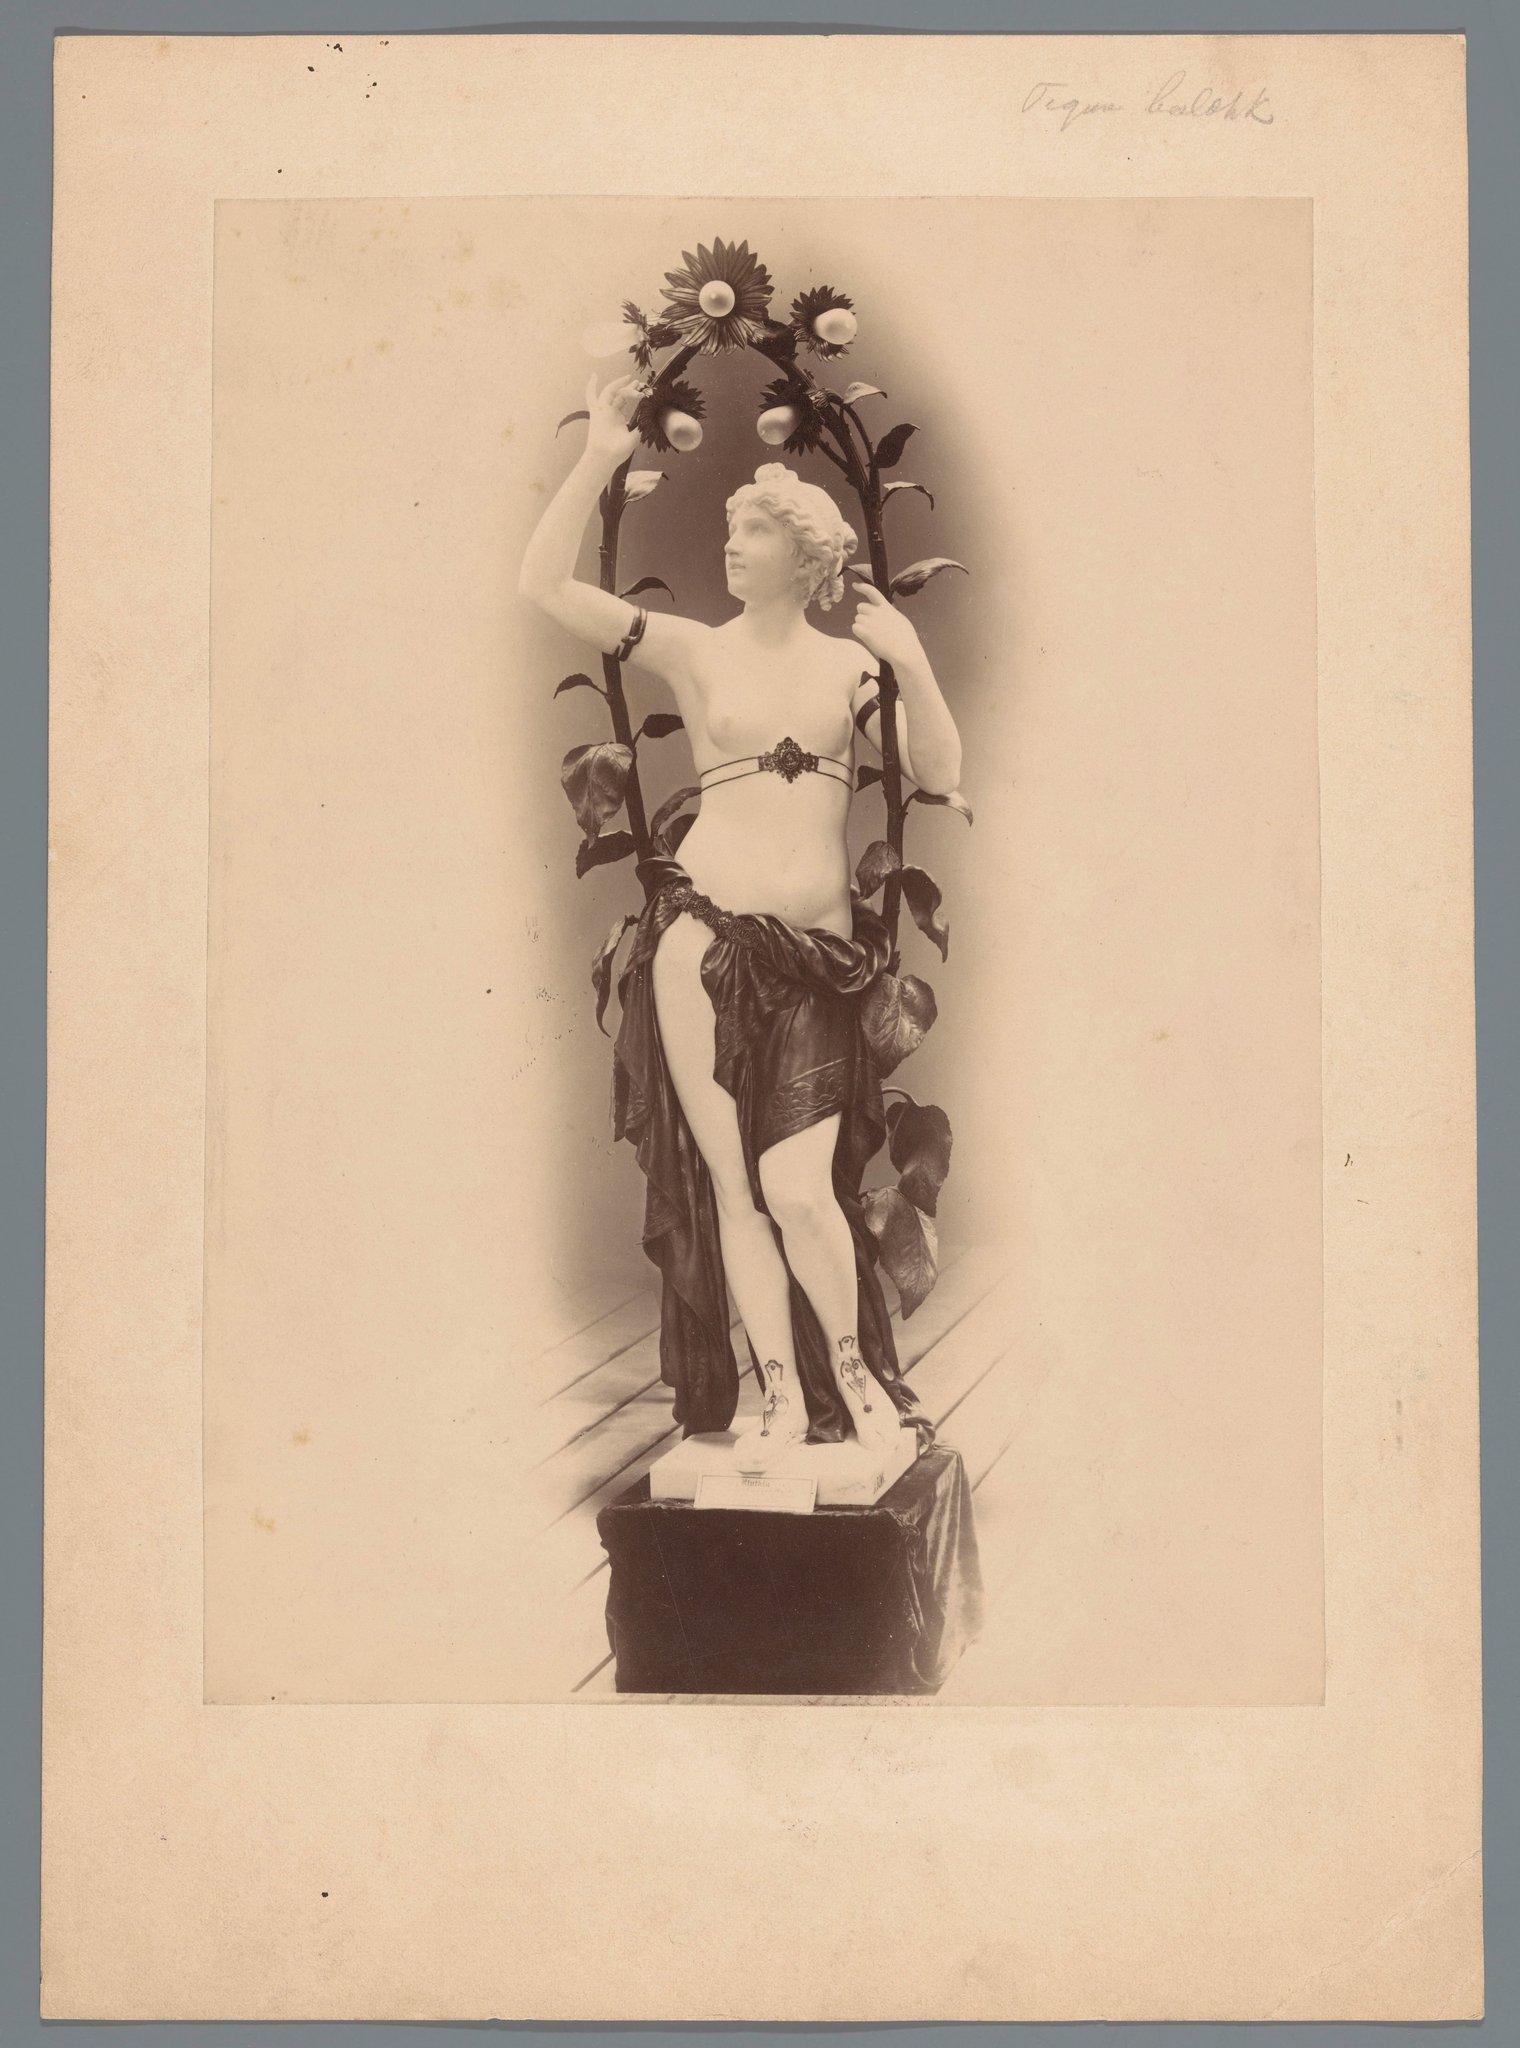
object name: photograph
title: Beeld van Clythia door C. Kundmann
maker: Anonymous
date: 1875-1900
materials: cardboard, photographic support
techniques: albumen print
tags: flowers, woman (showing herself) undressed, quasi-nude, sculpture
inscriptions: inscription: ‘Wien. Klythia von Prof. Kundmann.’, name: ‘J. A. G. DE LEUR Représentant Huigenspark 40b DEN HAAG.’, inscription: ‘XI pl 9’, collector's mark: Lugt 3937, inscription: ‘[...] beeldhk’